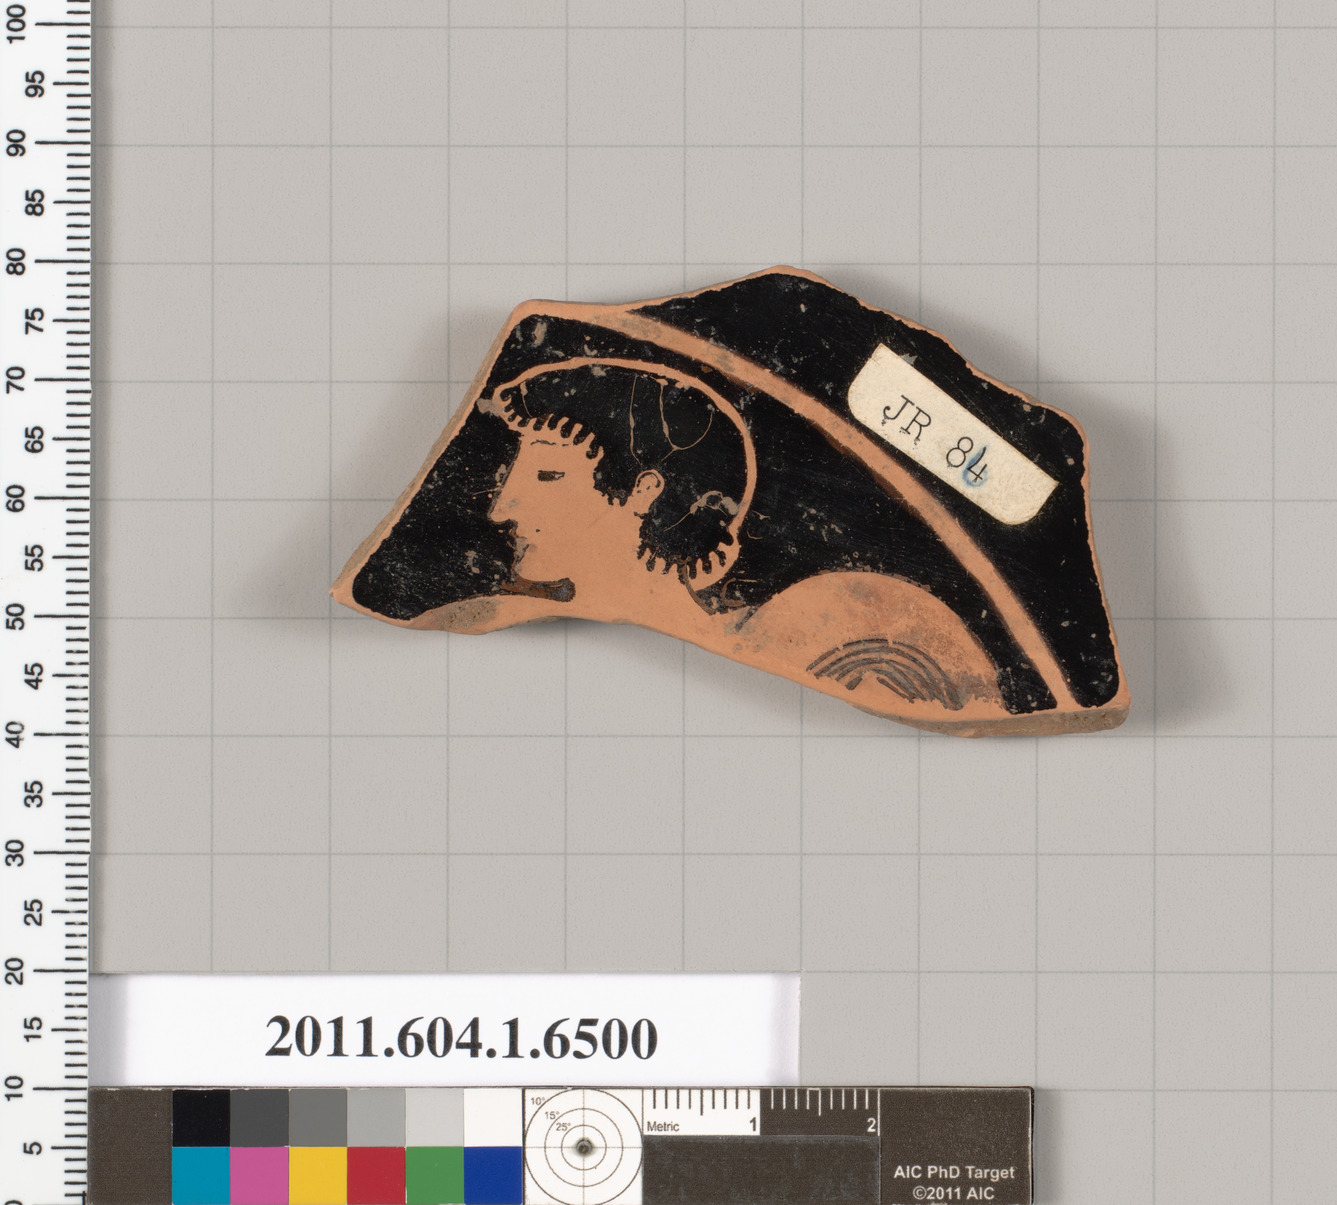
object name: kylix fragment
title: Terracotta fragment of a kylix (drinking cup)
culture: greek, attic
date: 490-480 BCE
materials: terracotta